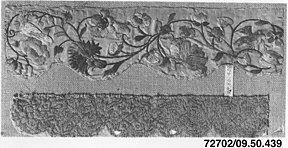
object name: fragment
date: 1701-1800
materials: metal thread, silk